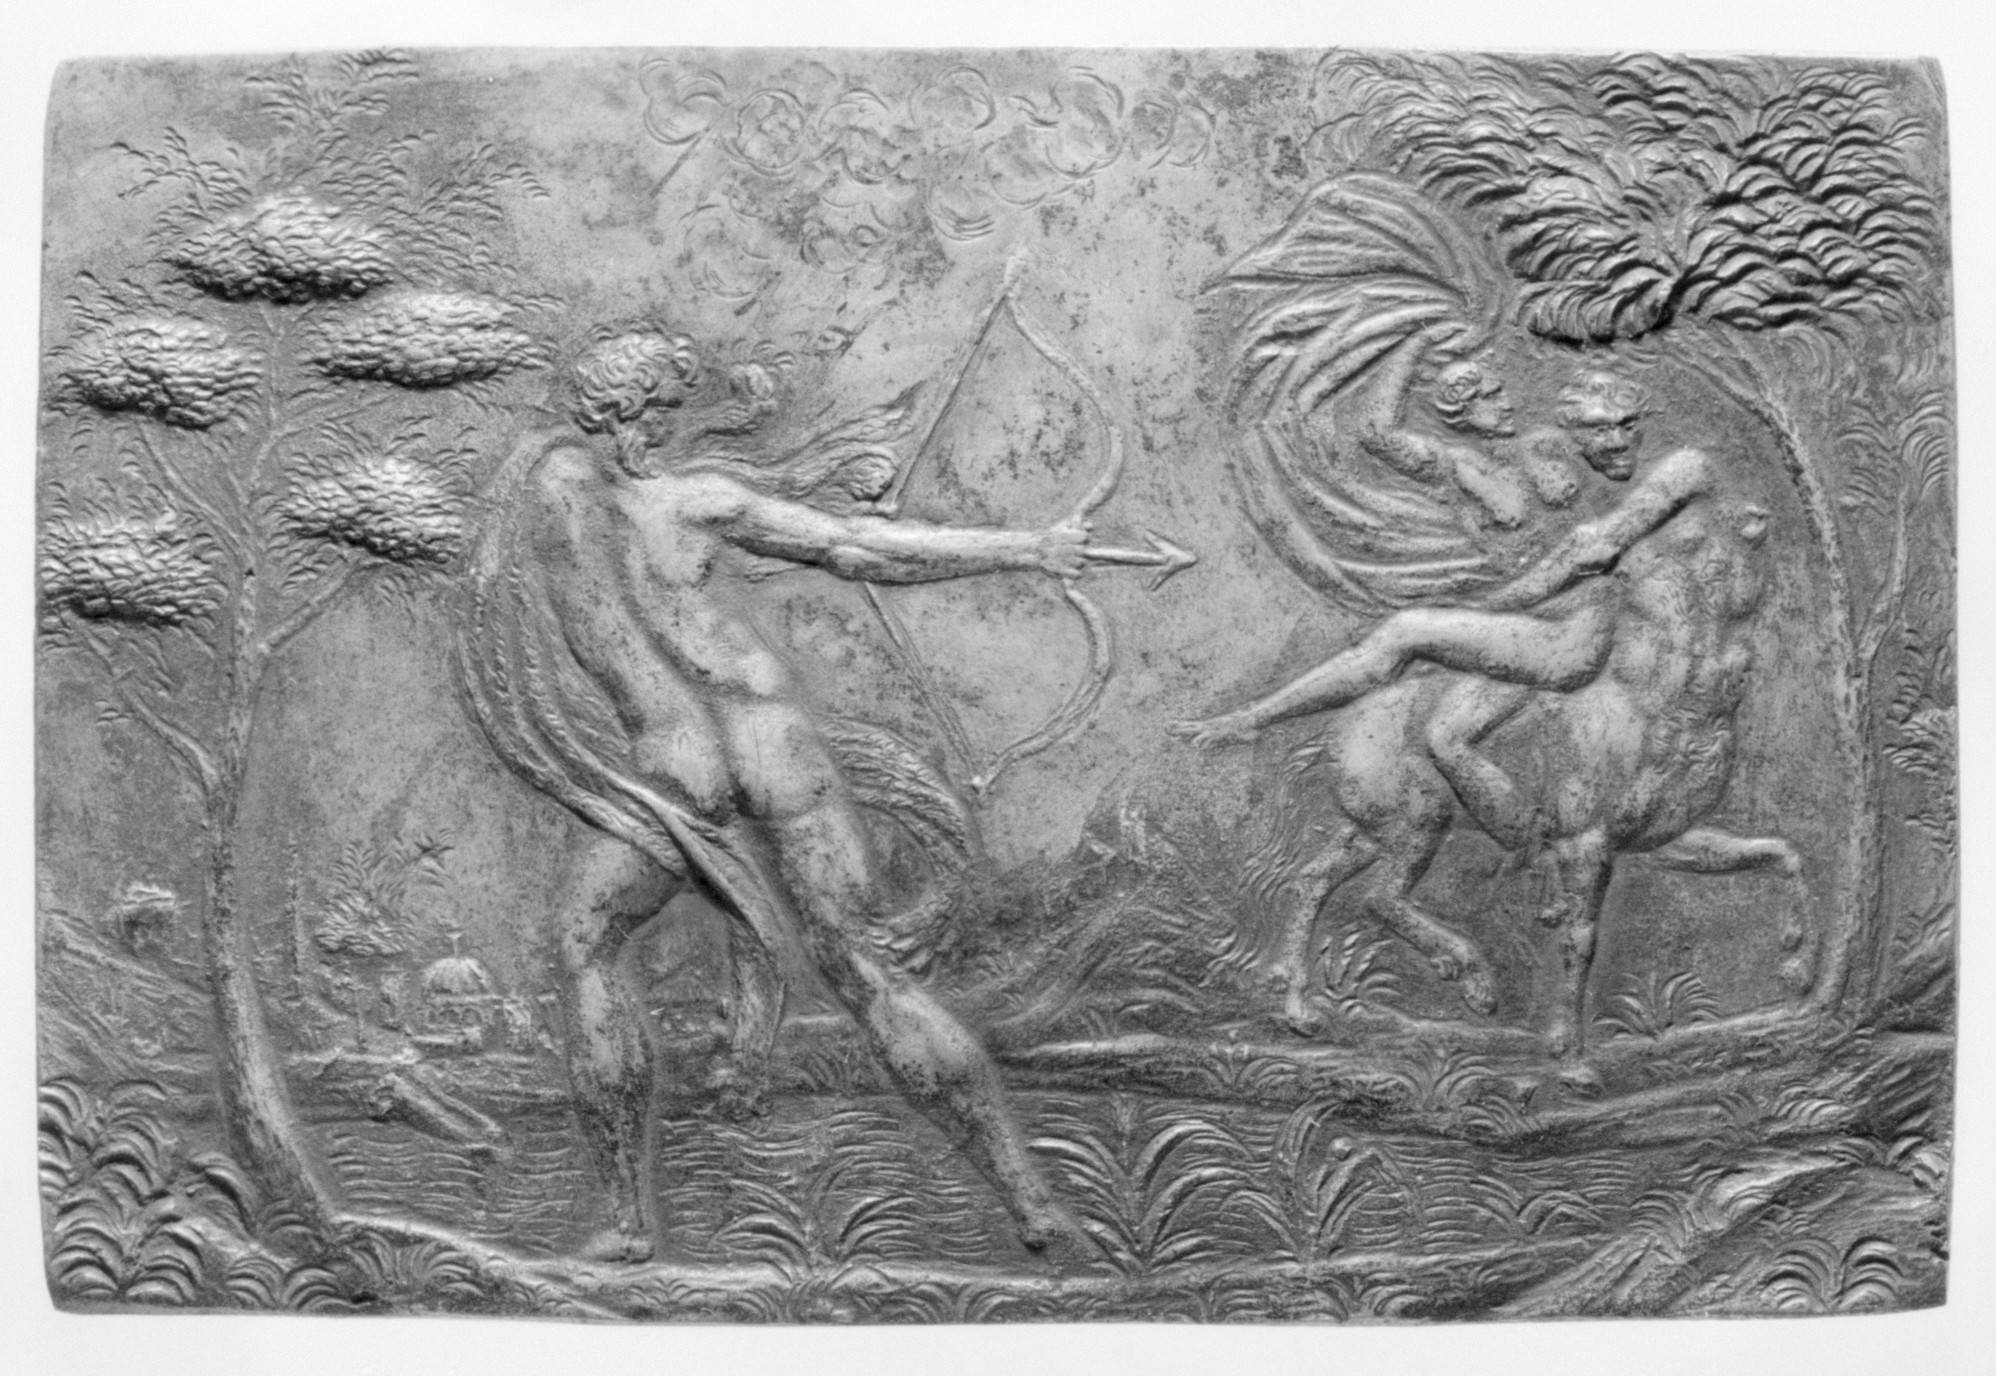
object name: plaquette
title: The Abduction of Dejanira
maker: annibale fontana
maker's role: artist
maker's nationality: italian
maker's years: 1540-1587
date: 1501-1600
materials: bronze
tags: bow and arrow,men,women,centaurs